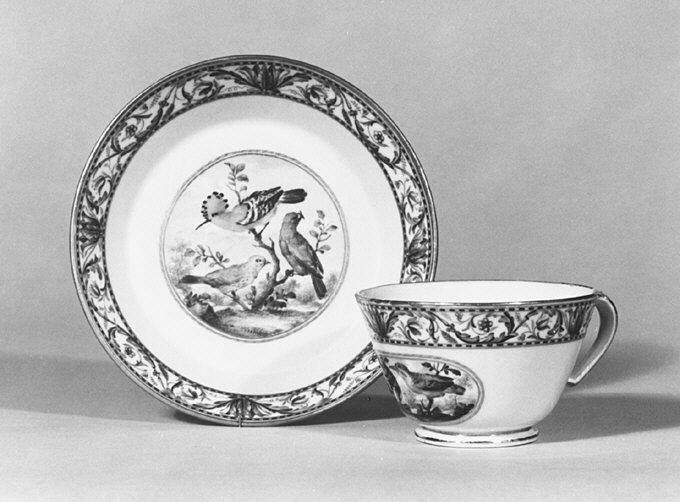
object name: saucer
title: Saucer (part of a service)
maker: meissen manufactory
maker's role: manufactory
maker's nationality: german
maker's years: 1710-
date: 1780-1785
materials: hard paste porcelain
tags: birds